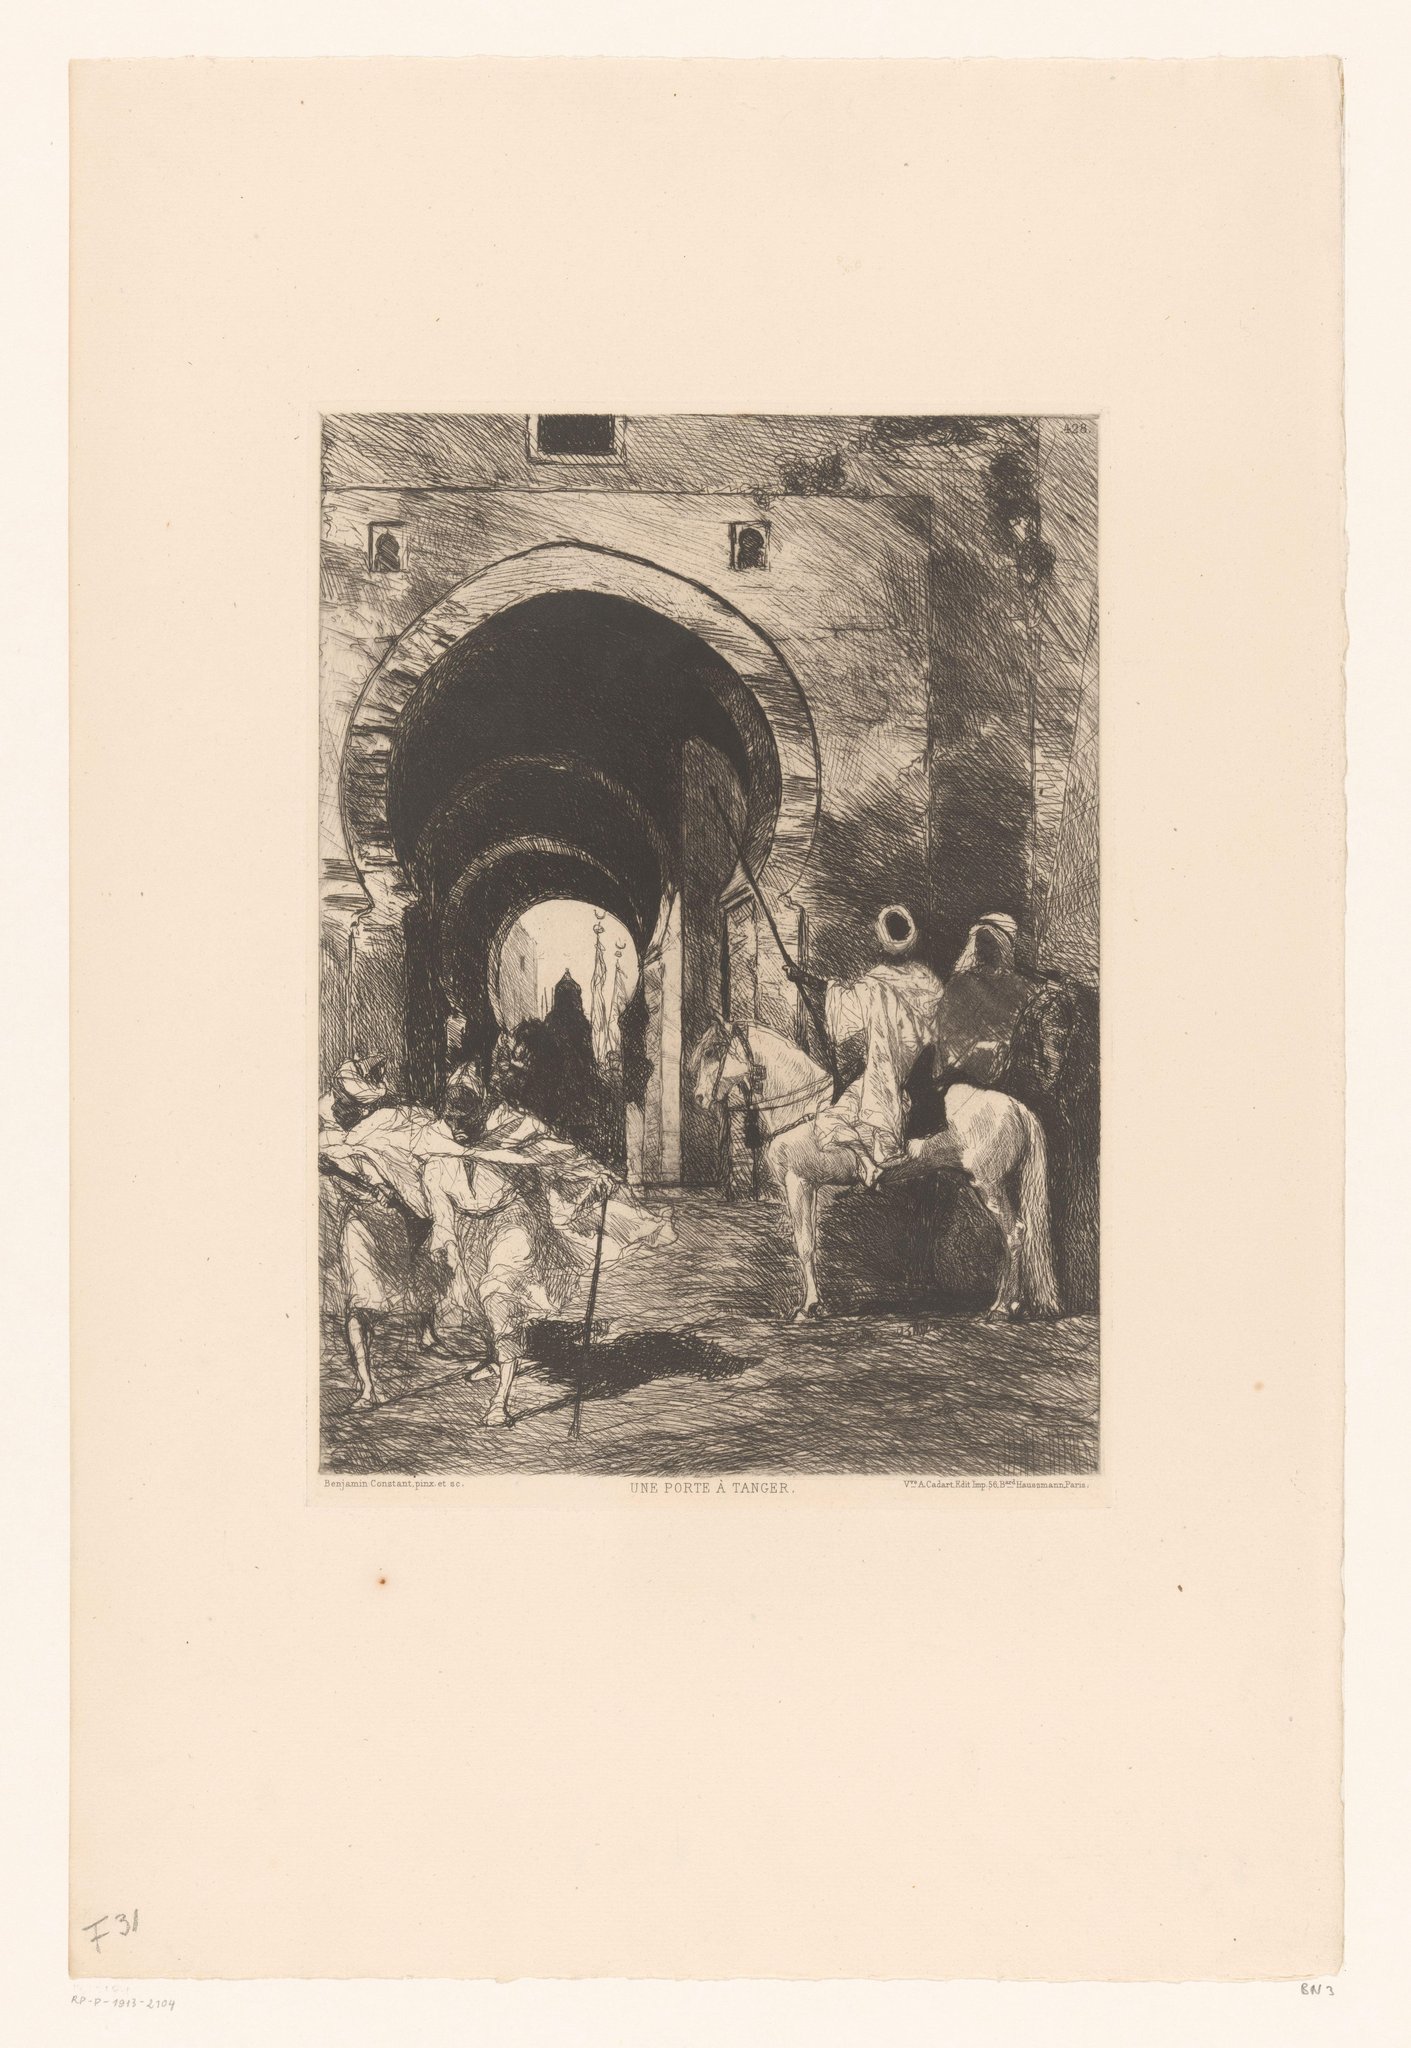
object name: print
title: Une porte à Tanger.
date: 1878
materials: paper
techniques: drypoint, etching, intaglio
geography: paris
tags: riding a horse, ass, or mule; rider, horseman, gate, entrance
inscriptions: collector's mark: Lugt 2233